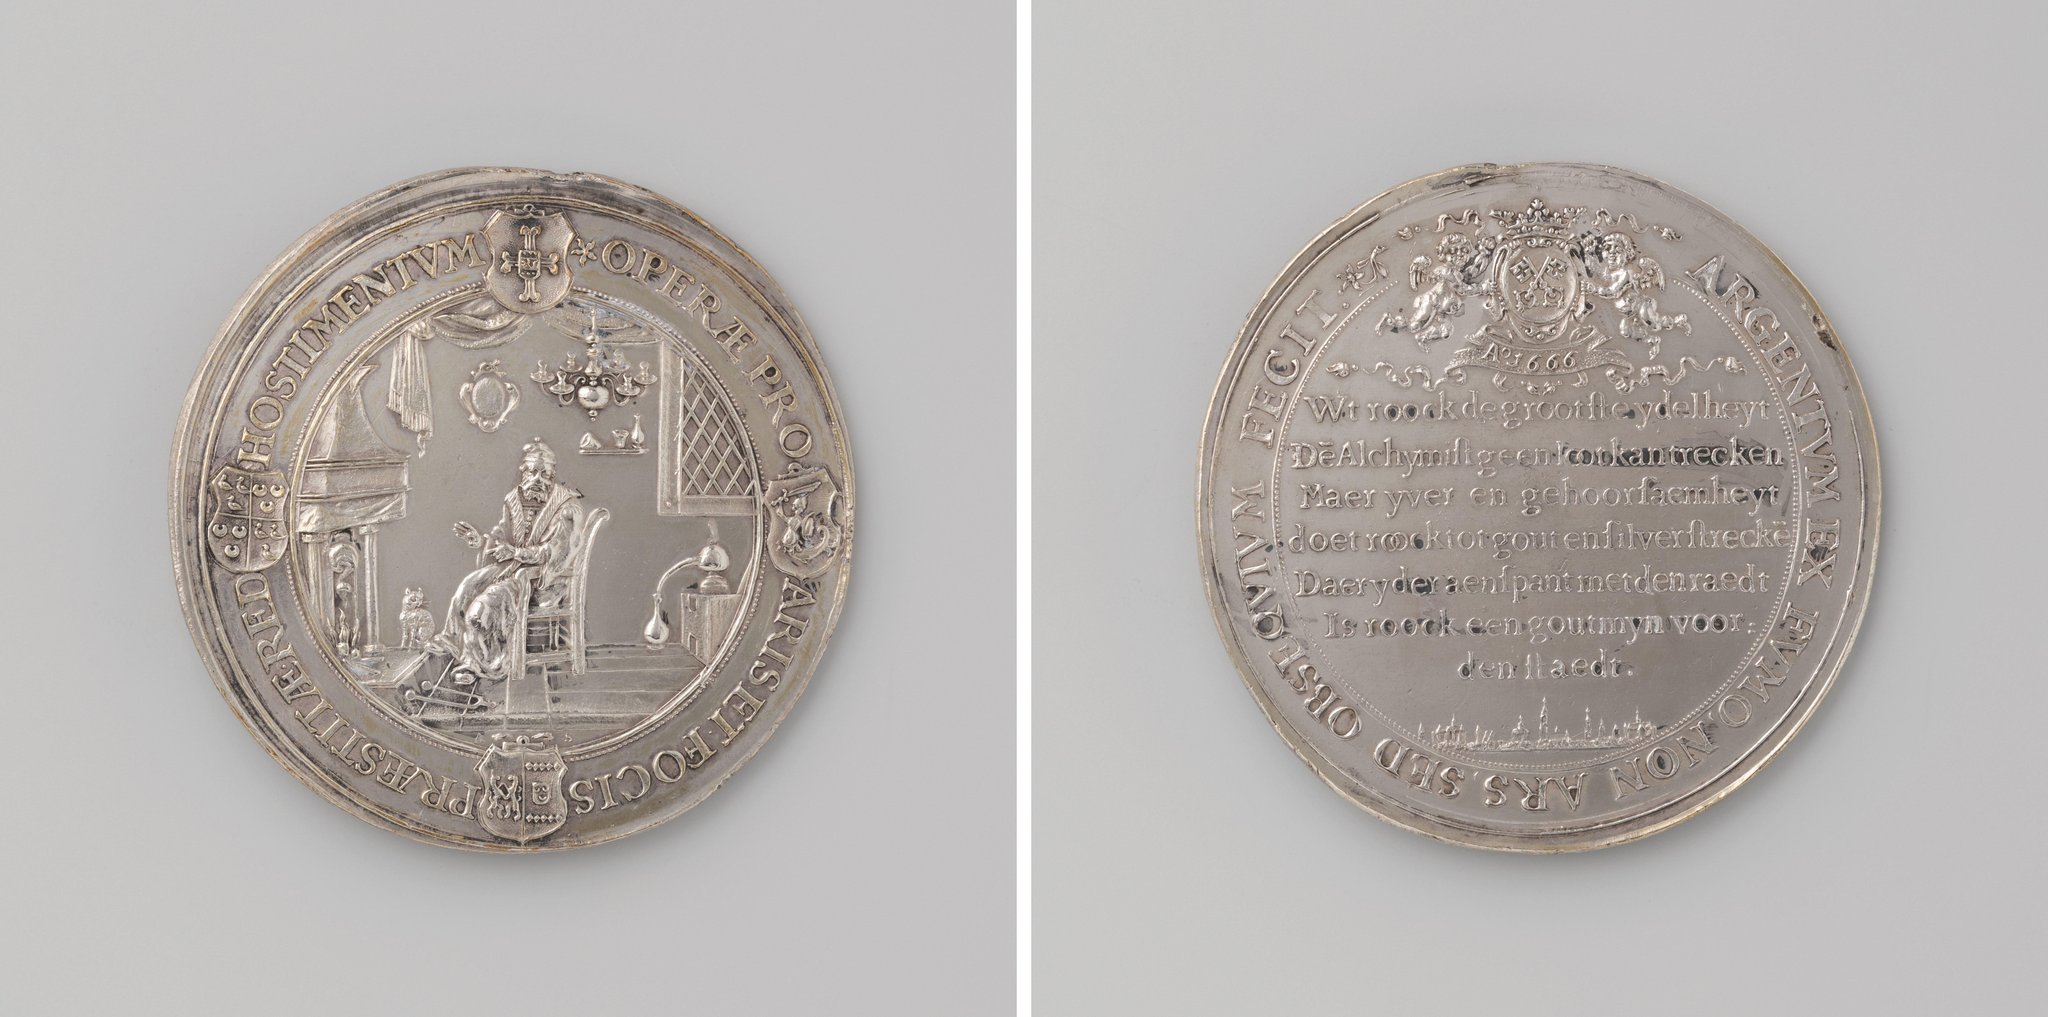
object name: history medal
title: Invordering van het bijzonder haardstedengeld in Leiden ter financiering van de oorlog tegen Engeland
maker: arent schmeltzing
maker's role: medailleur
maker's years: -1710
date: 1666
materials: silver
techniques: casting, striking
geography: leiden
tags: leiden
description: Zilveren penning. Voorzijde: man zittend op stoel bij haard binnen omschrift met vier wapenschilden. Keerzijde: opschrift onder gekroond wapenschild met twee engeltjes en boven gezicht op stad binnen omschrift.